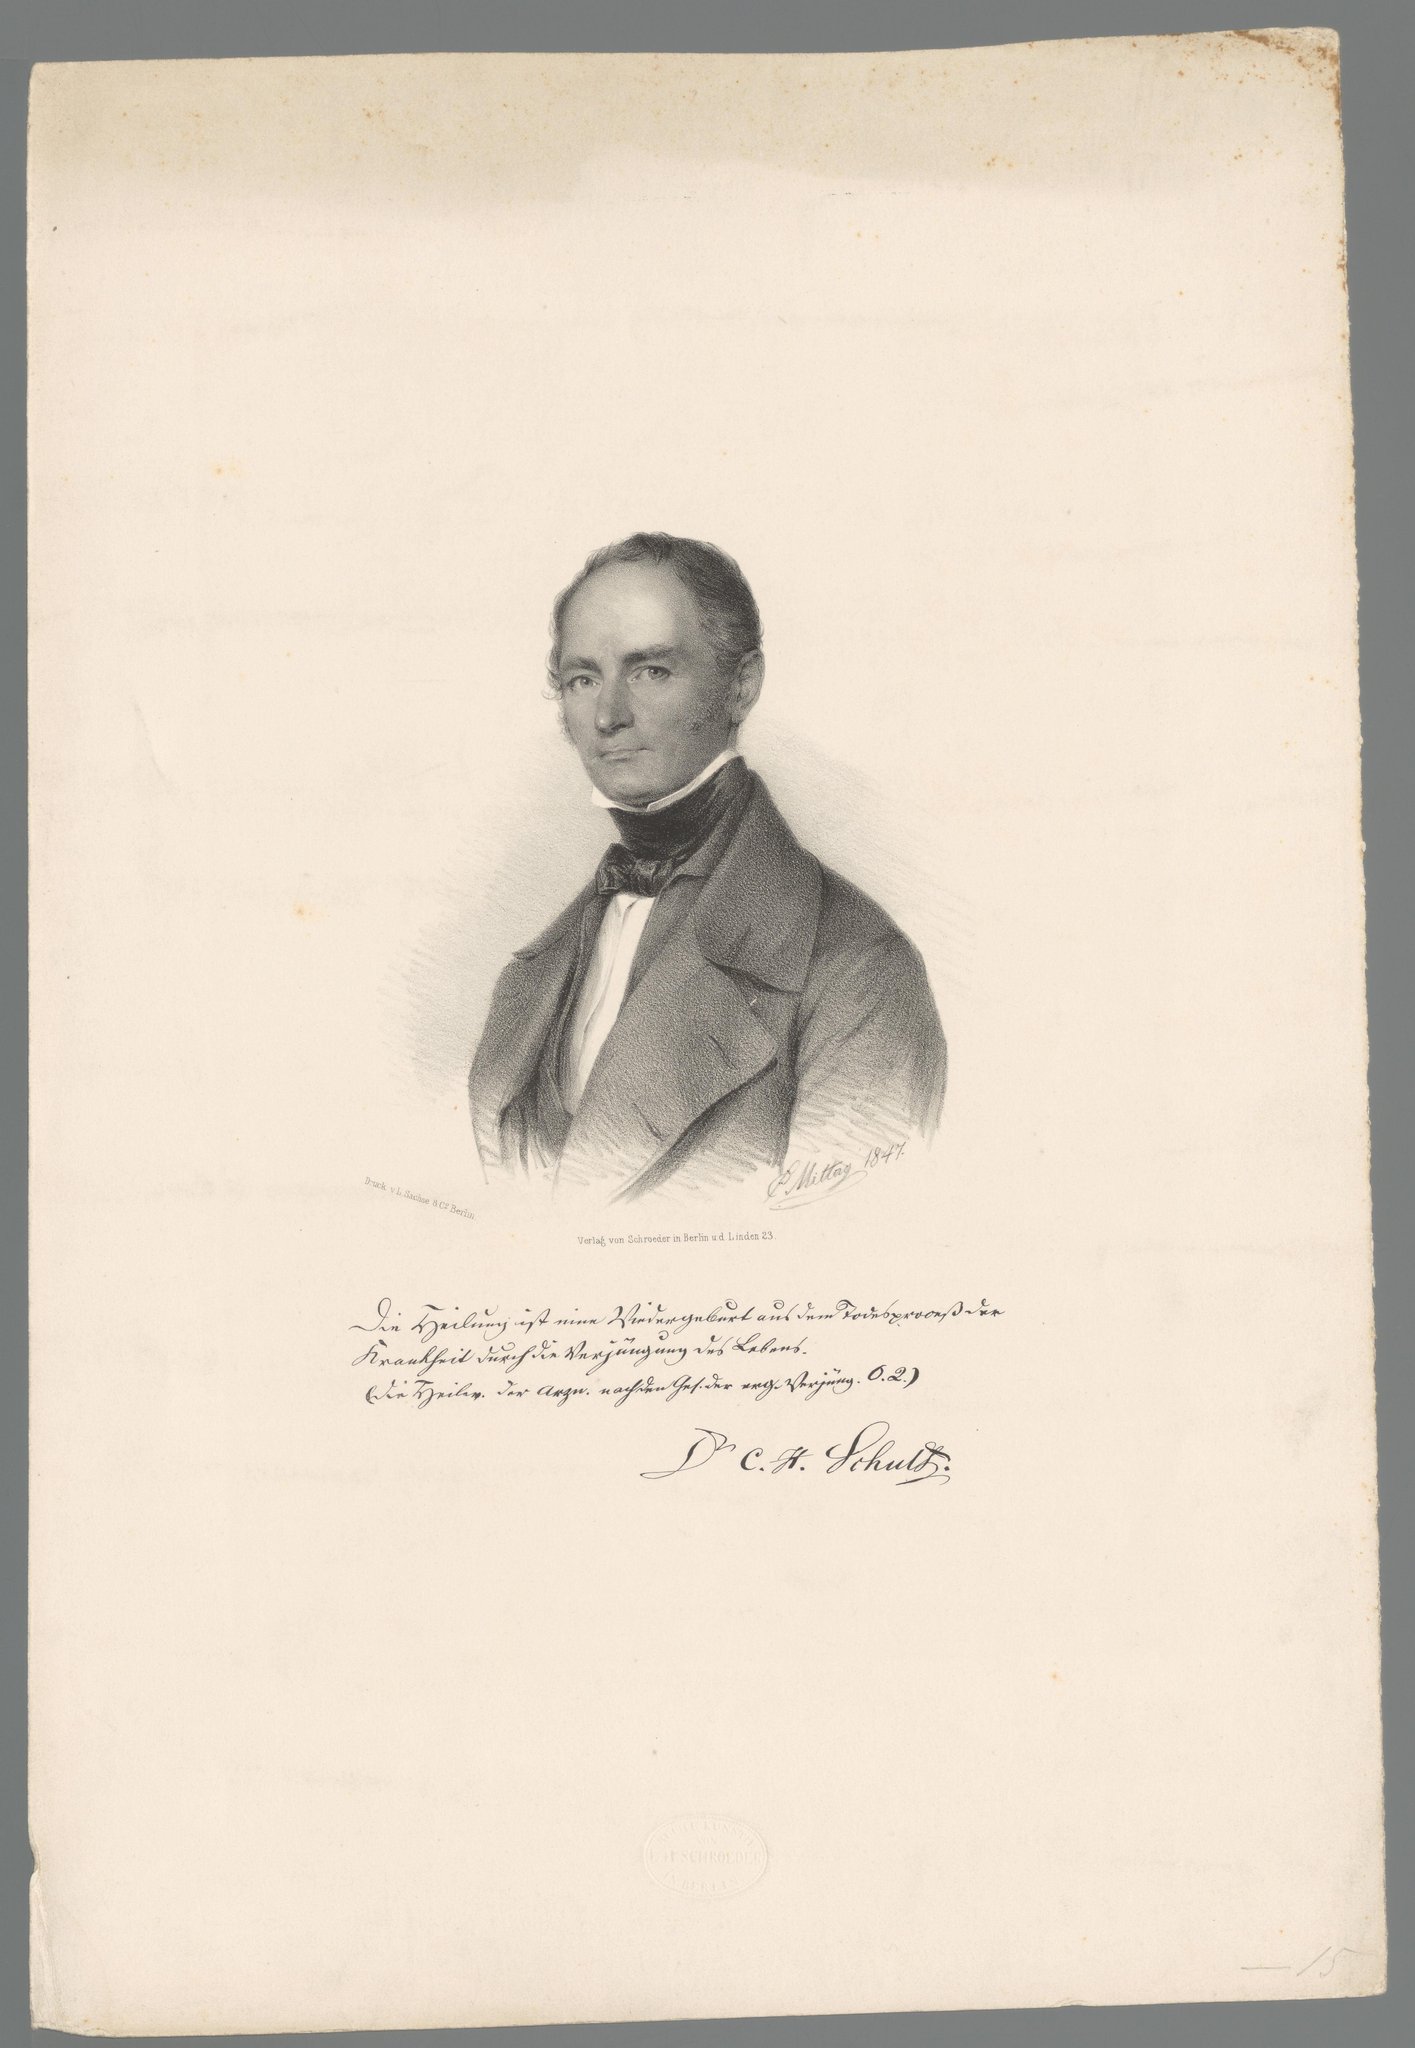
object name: print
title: Portret van een onbekende man, mogelijk C.H. Schultz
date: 1847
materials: paper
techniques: lithograph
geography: berlin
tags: adult man, historical persons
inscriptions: collector's mark: Lugt 2228, check stamp: ‘Buch u:kunsth. von E.H. Schroeder in Berlin’